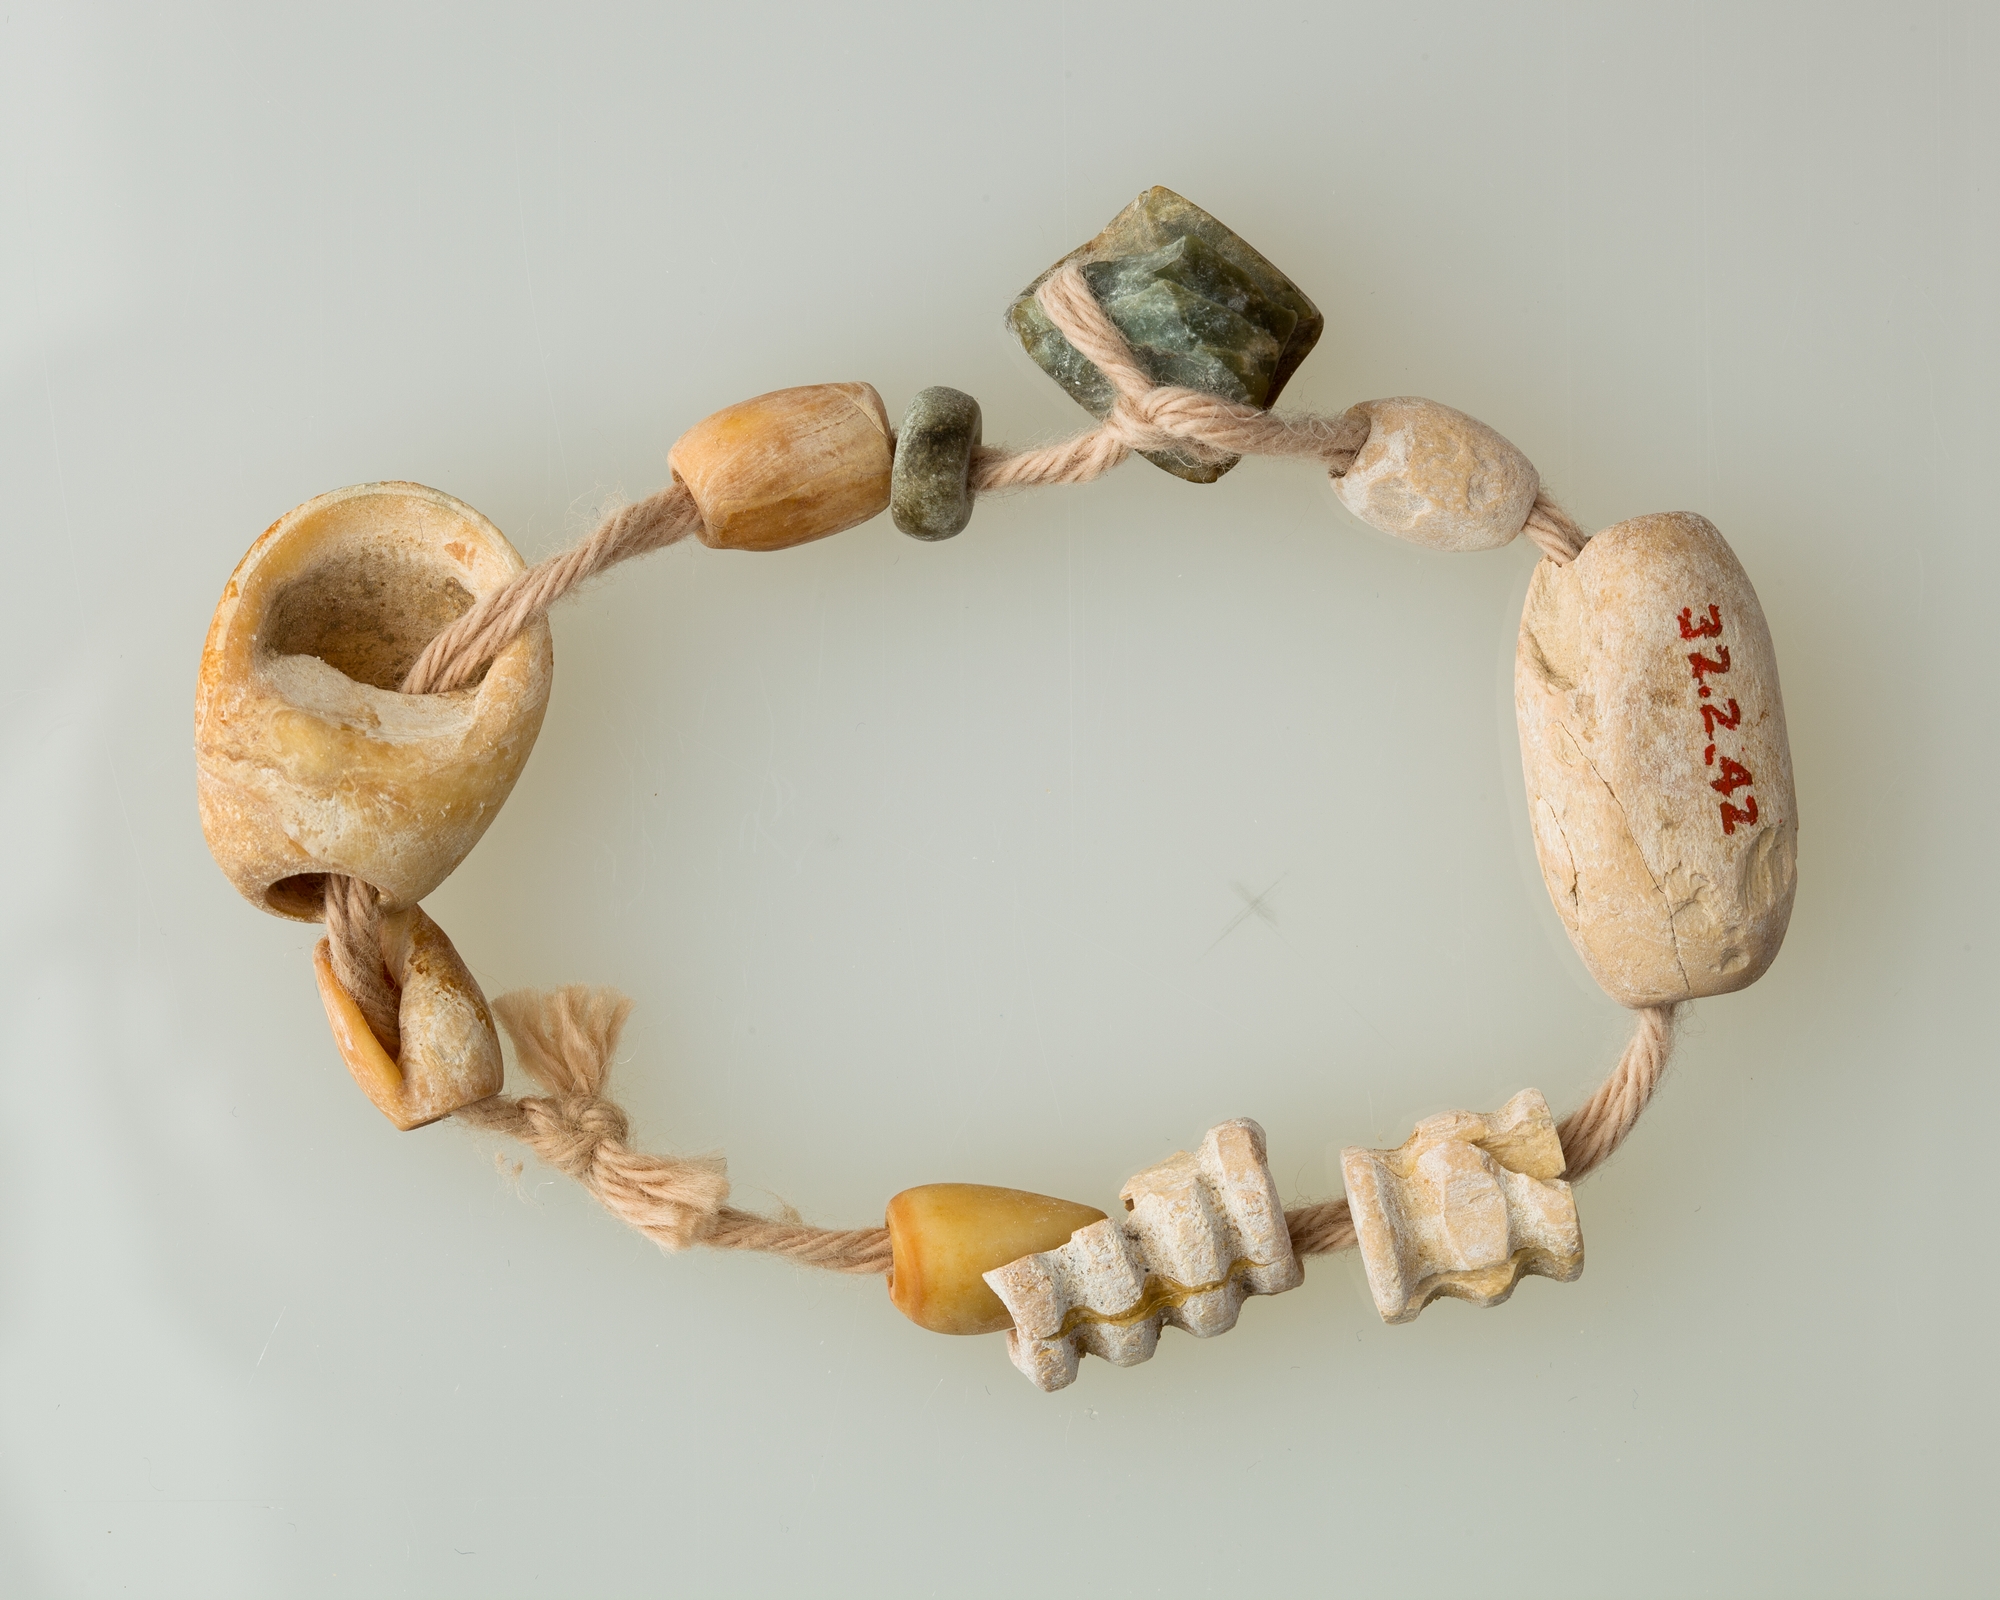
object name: bead, string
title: String of beads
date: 4400-3800 BCE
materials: bone, stone, shell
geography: egypt